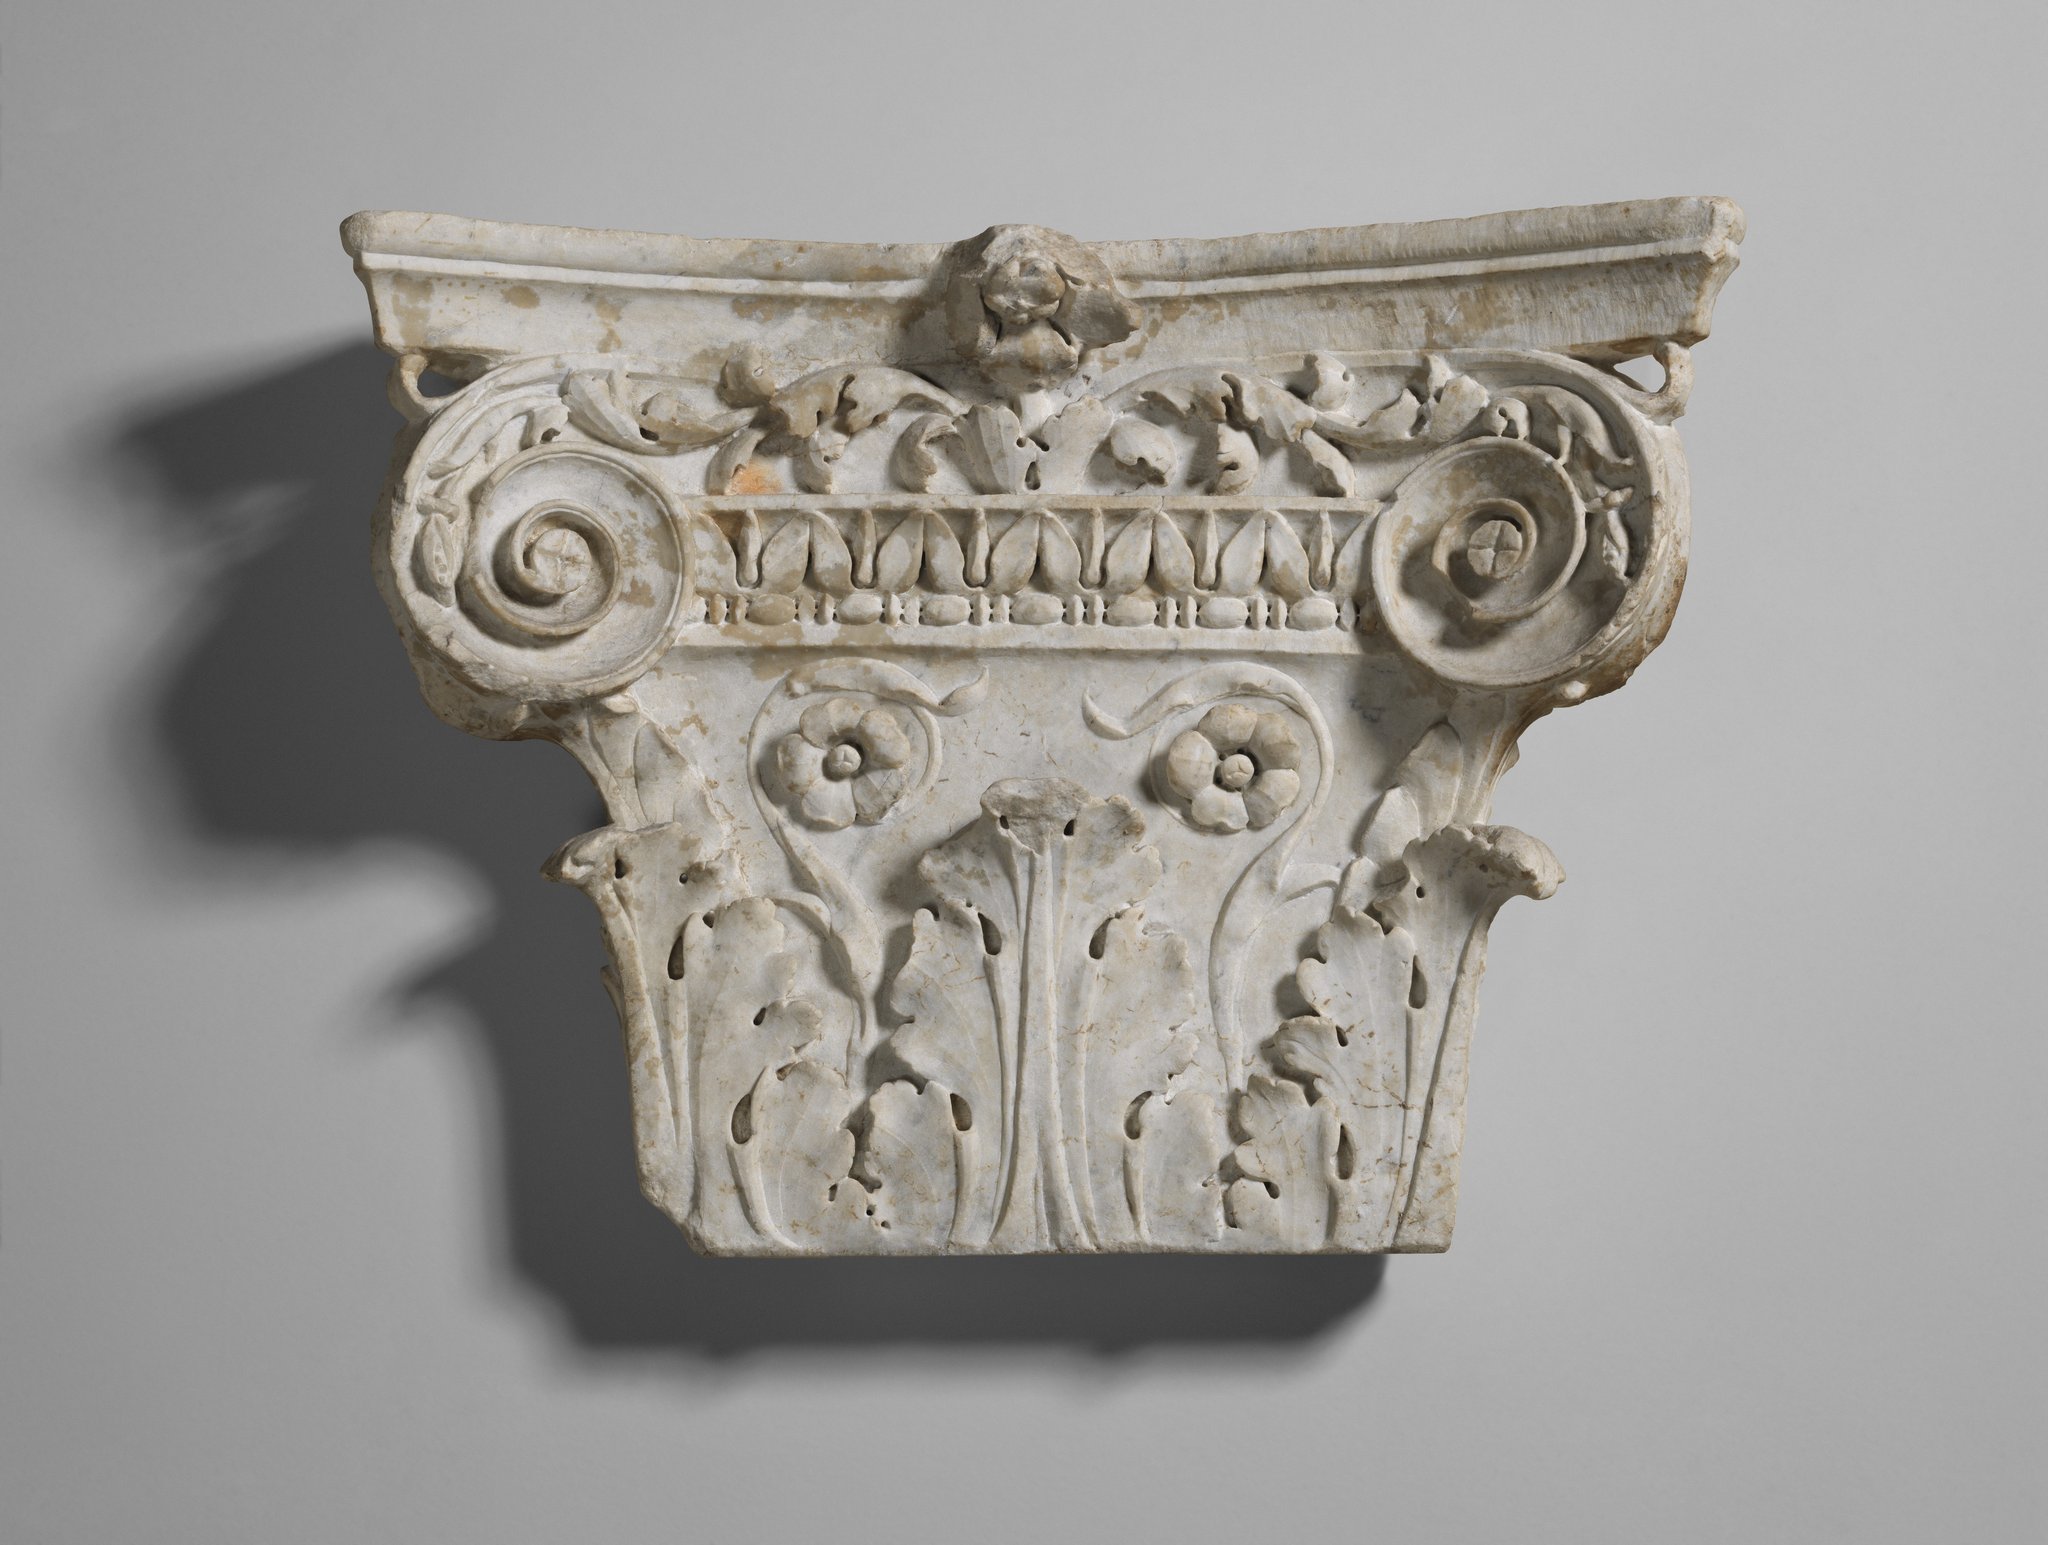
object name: capital, corinthian composite pilaster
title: Marble pilaster capital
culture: roman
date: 1-50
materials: marble